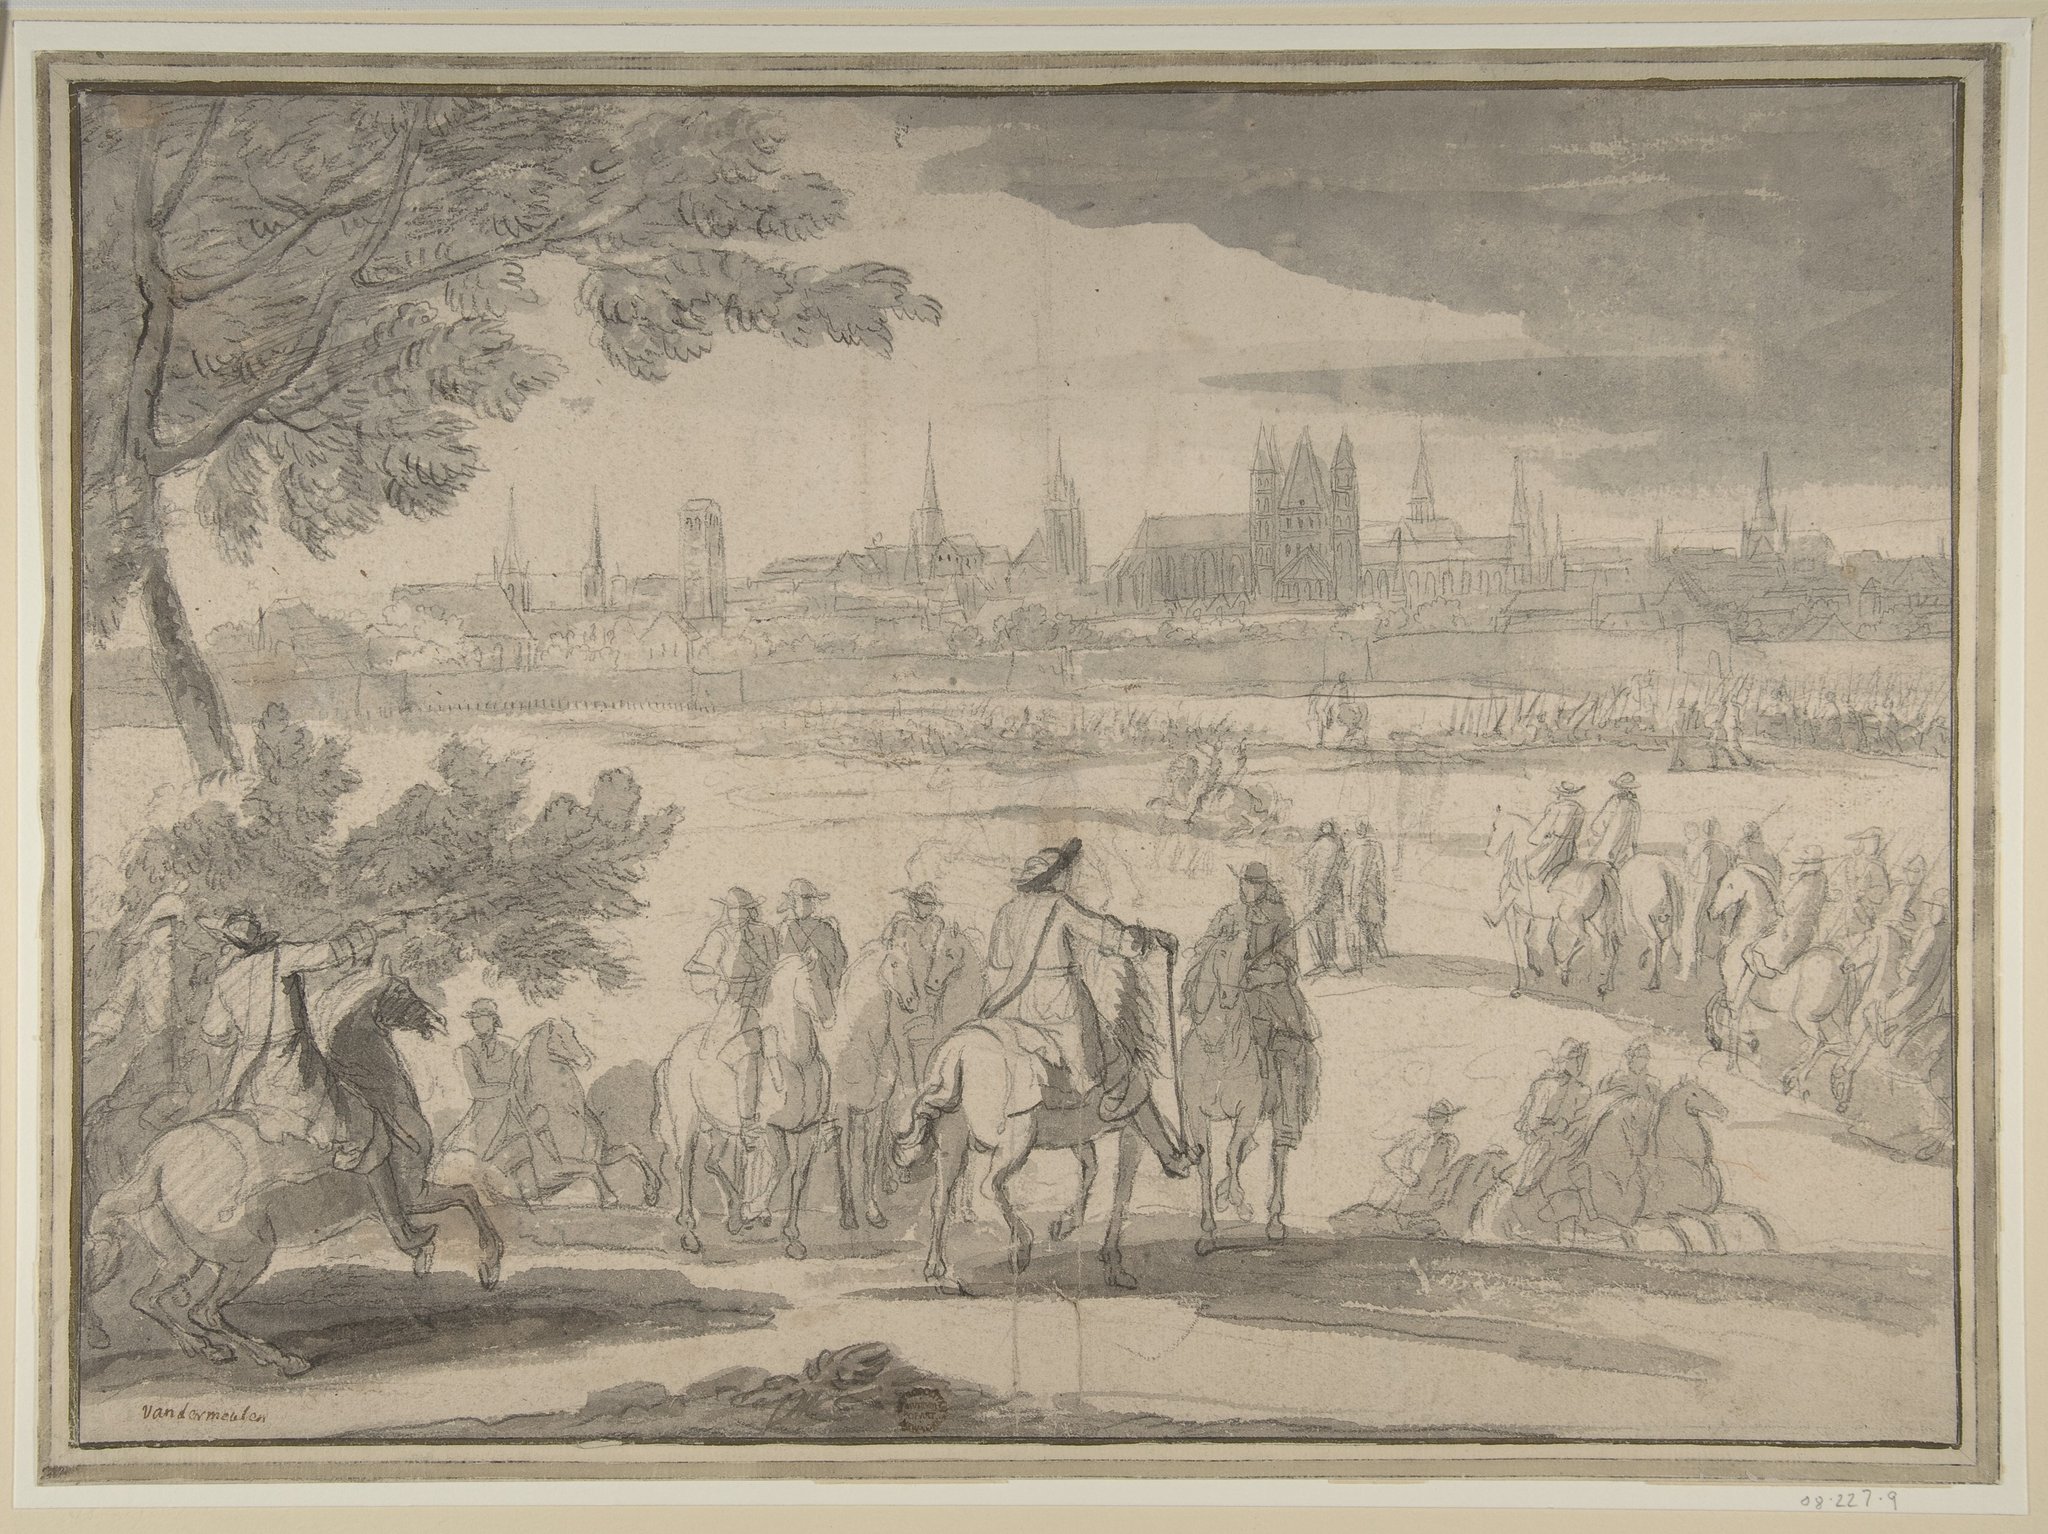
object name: drawing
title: Louis XIV at the Siege of Tournai, Seen from the North-East (June 21–25, 1667)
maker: adam frans van der meulen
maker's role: artist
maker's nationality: flemish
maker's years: 1632-1690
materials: chalk, ink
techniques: brush, pen, wash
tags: buildings,louis xiv,horses,trees